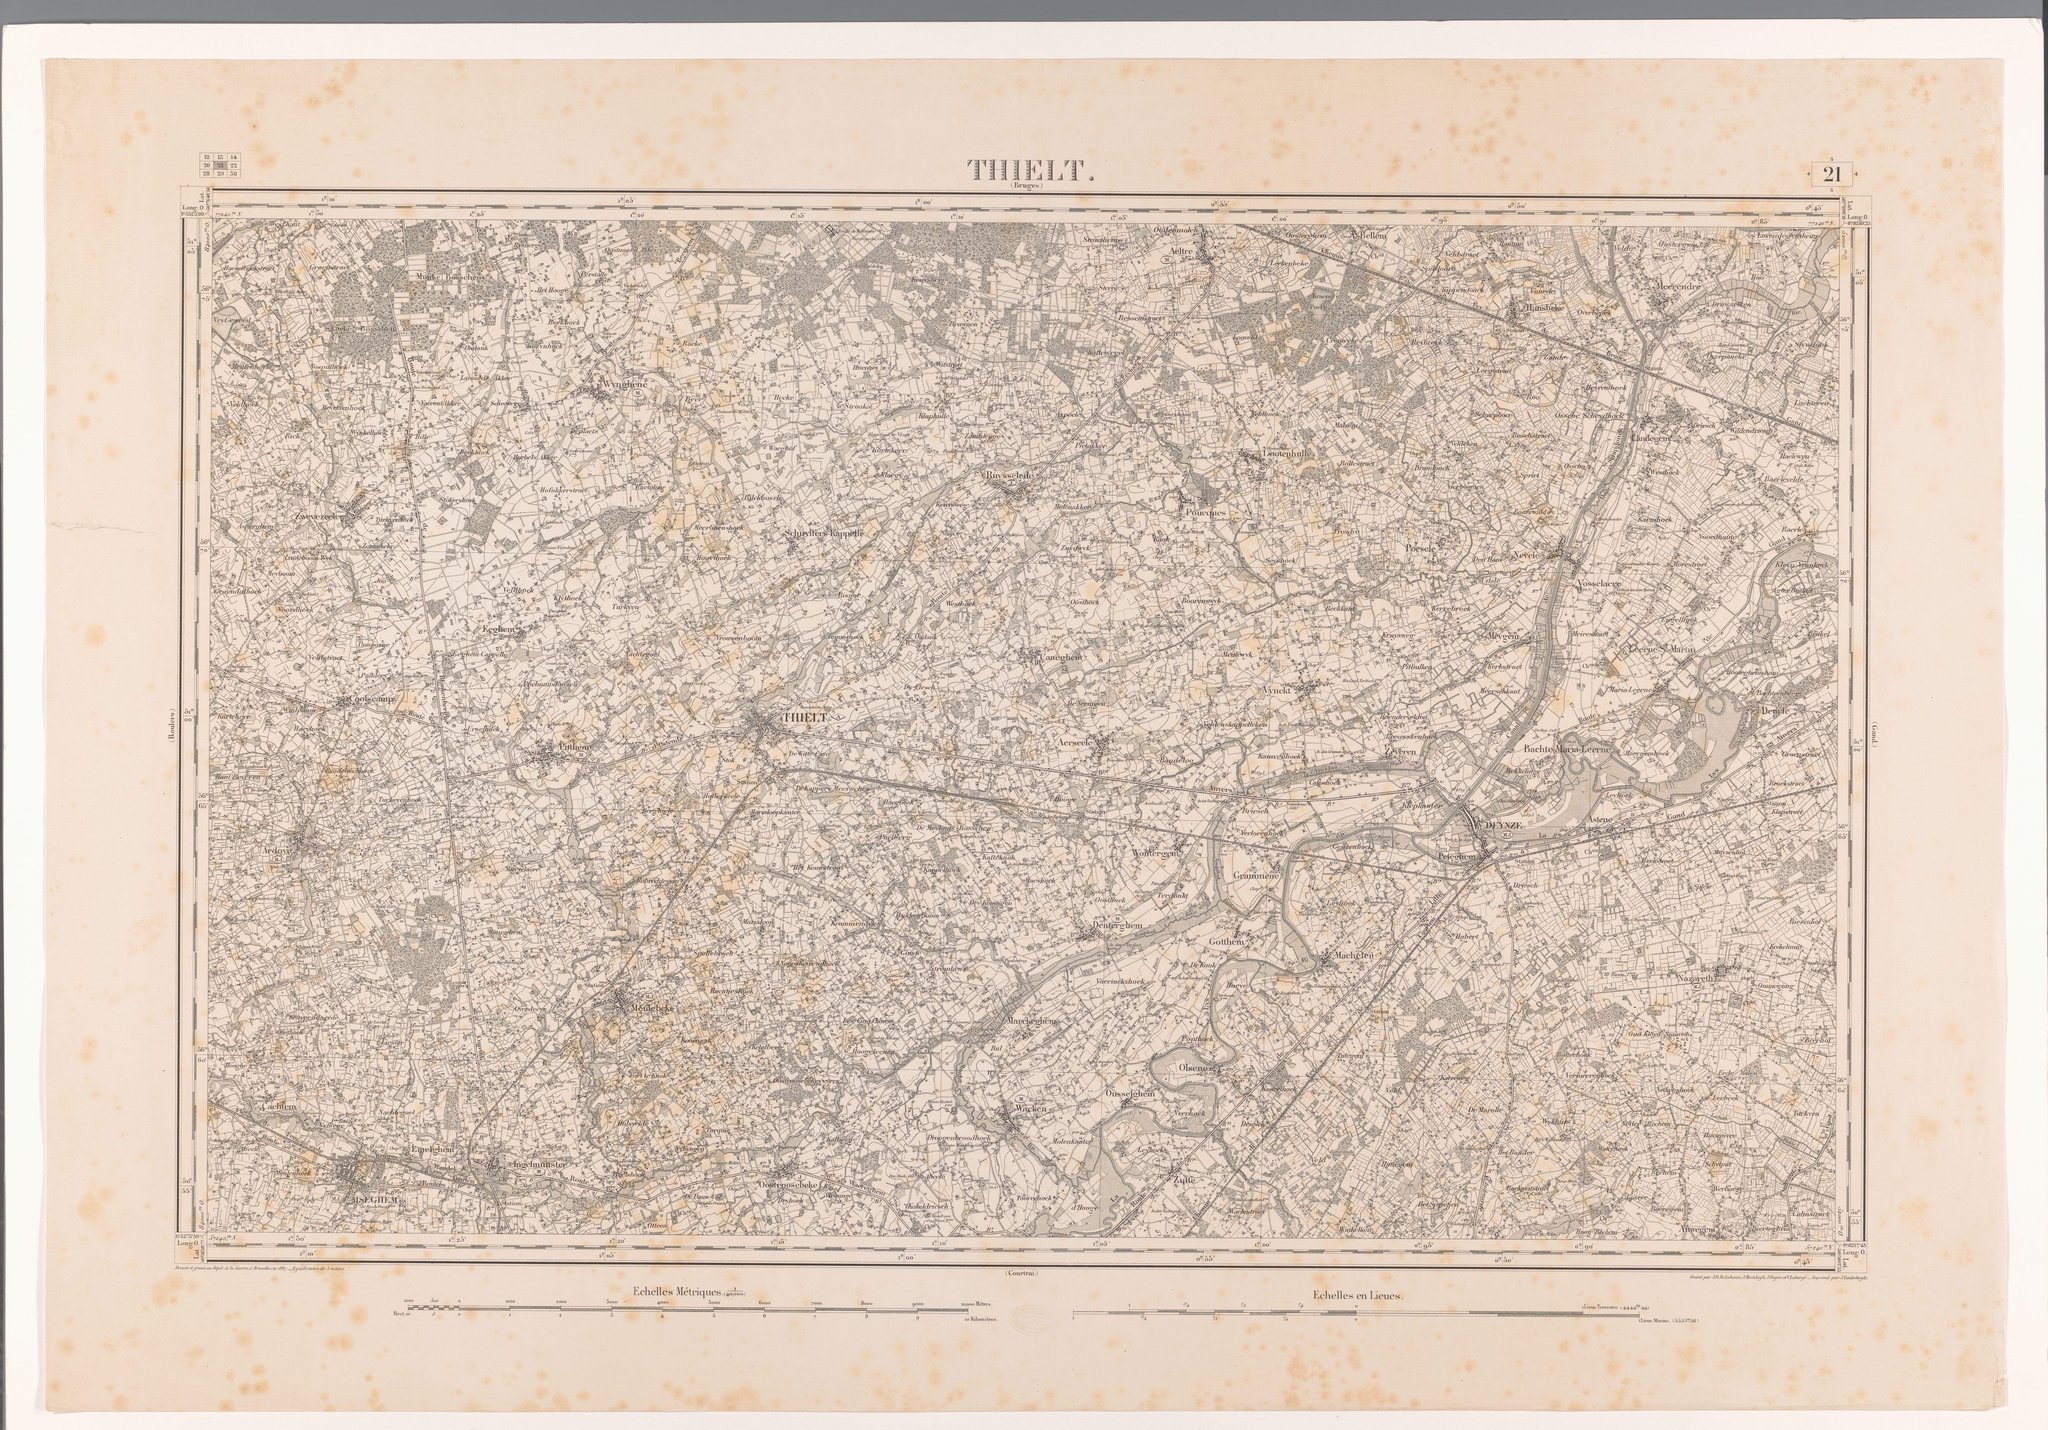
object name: print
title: Kaart van de omgeving van Tielt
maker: j. vanderborght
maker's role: printer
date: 1867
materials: paper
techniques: lithograph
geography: brussels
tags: maps of separate countries or regions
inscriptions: check stamp: ‘Depot de la Guerre Belgique’